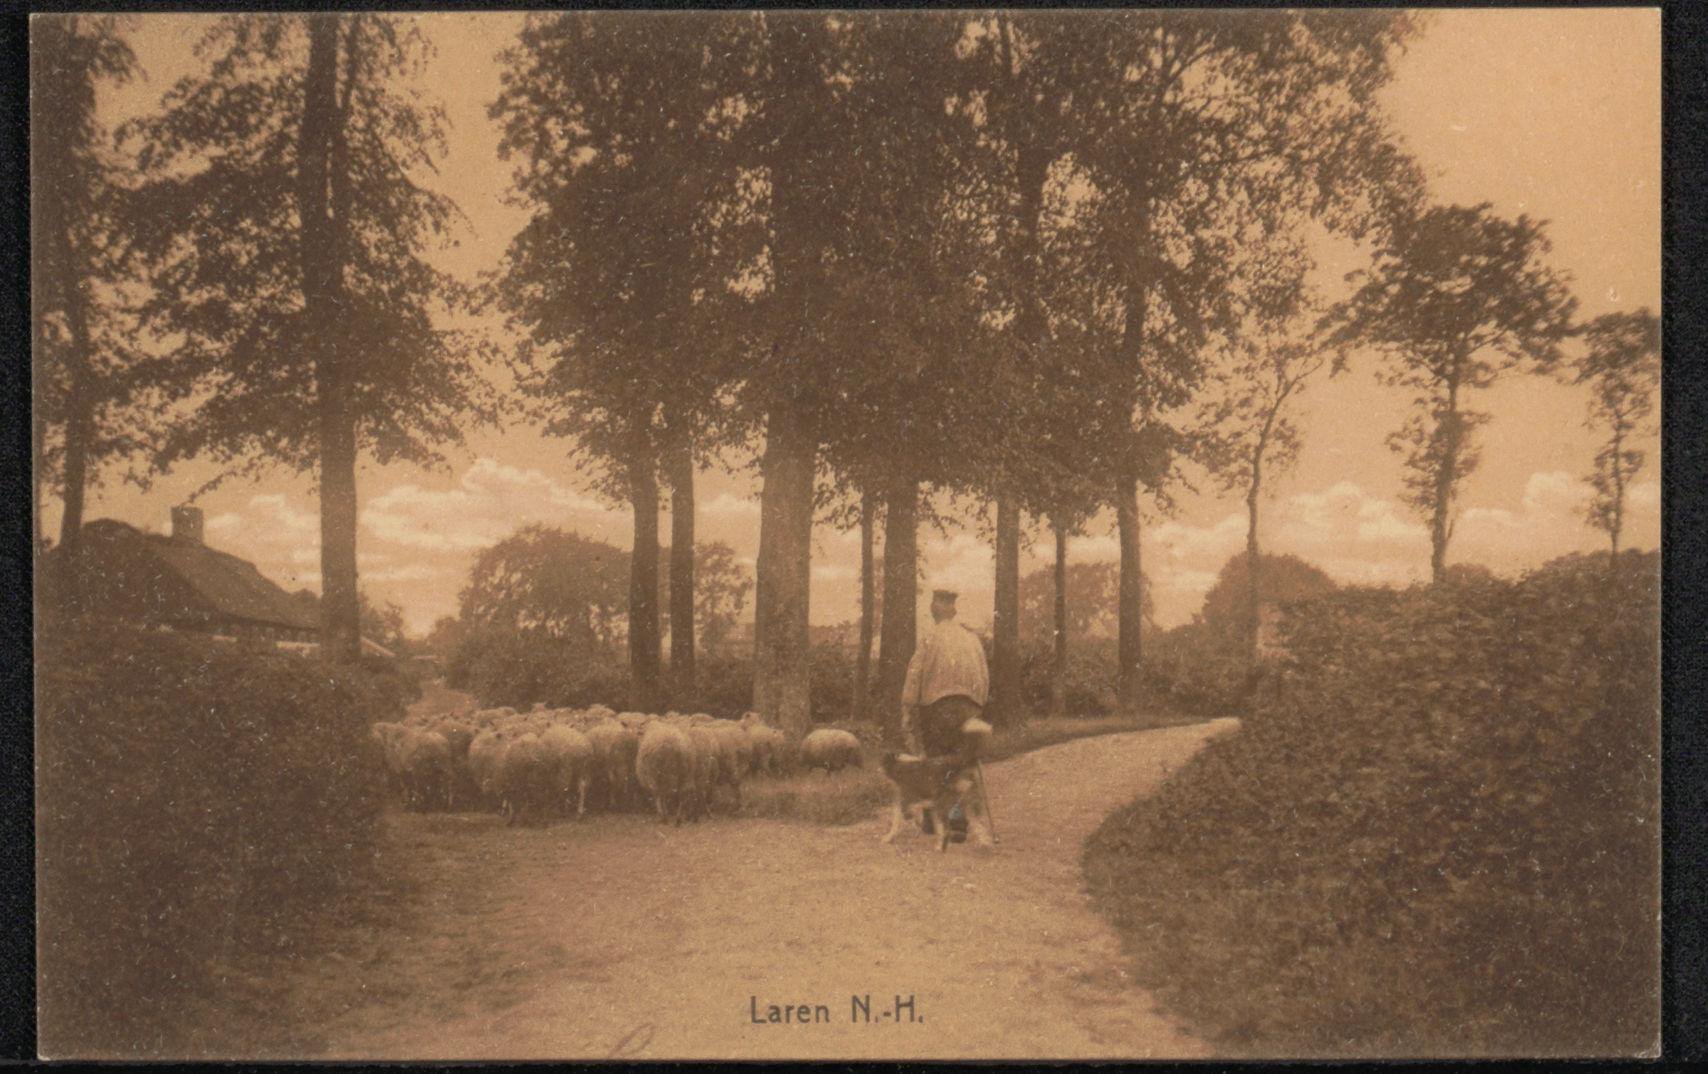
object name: ansichtkaart, prentbriefkaart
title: Prentbriefkaart aan Saskia Delprat-Veth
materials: cardboard, ink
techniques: photograph, pen, writing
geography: laren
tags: amsterdam, saskia delprat-veth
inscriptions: collector's mark: ‘RPK’